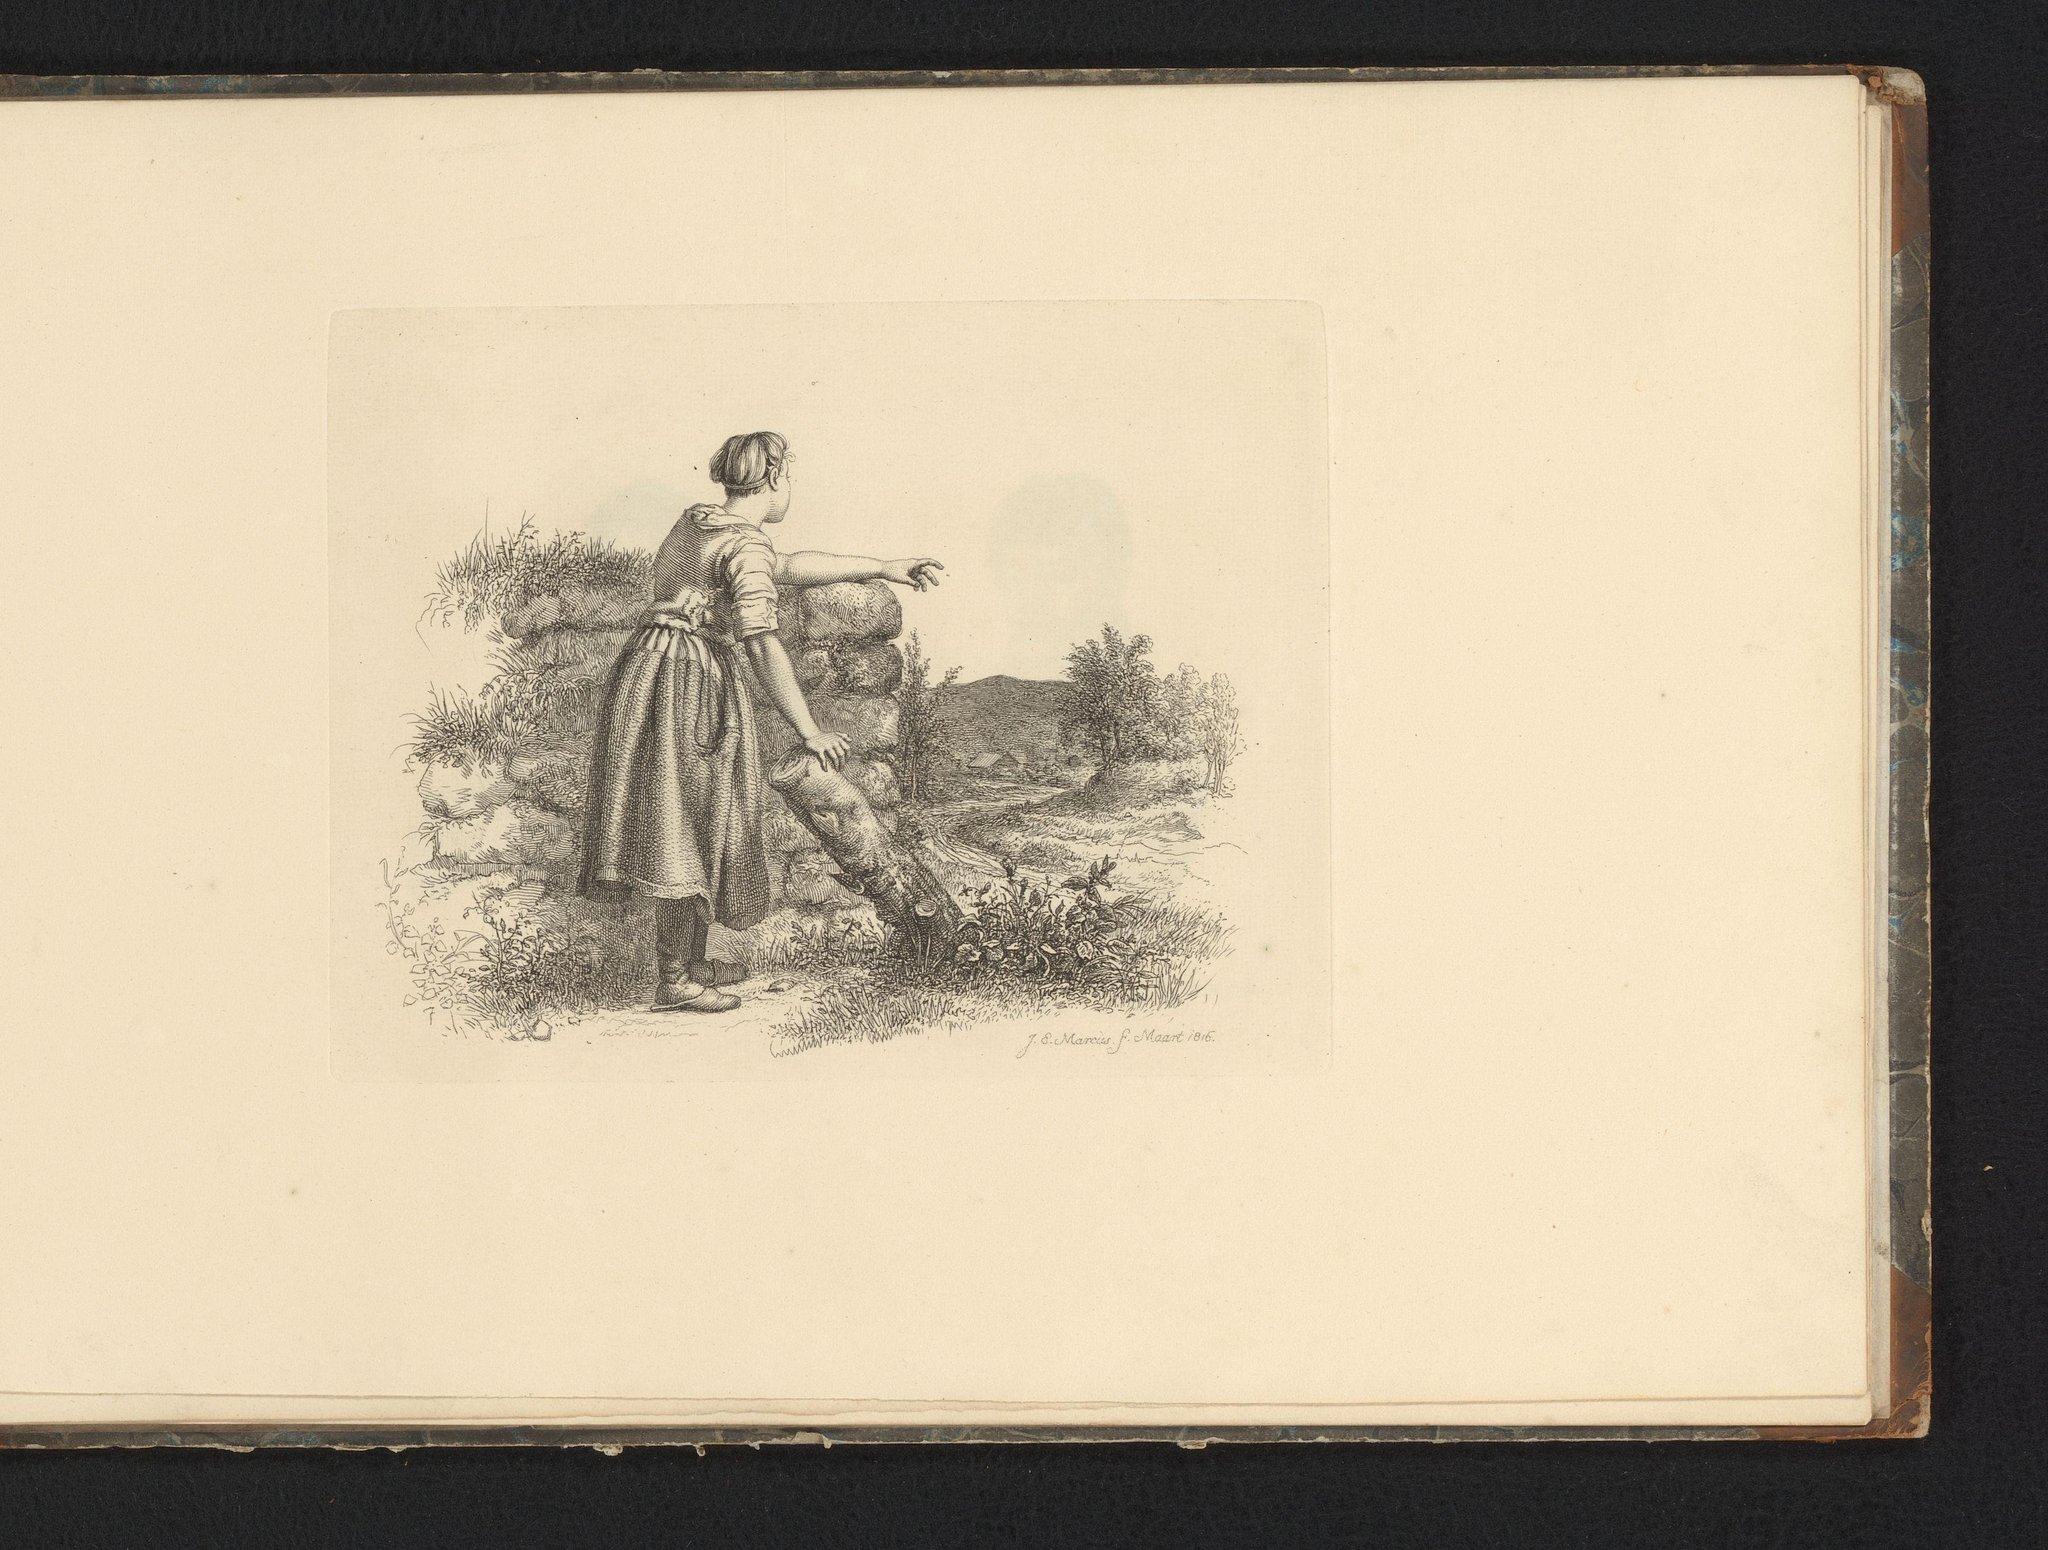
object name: album leaf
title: Jonge vrouw leunend op een lage muur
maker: jacob ernst marcus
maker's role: draughtsman, print maker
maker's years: 1774-1826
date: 1803-1816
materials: paper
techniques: etching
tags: sleeping on the ground, leaning figure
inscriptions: date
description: Deze prent maakt deel uit van een album.